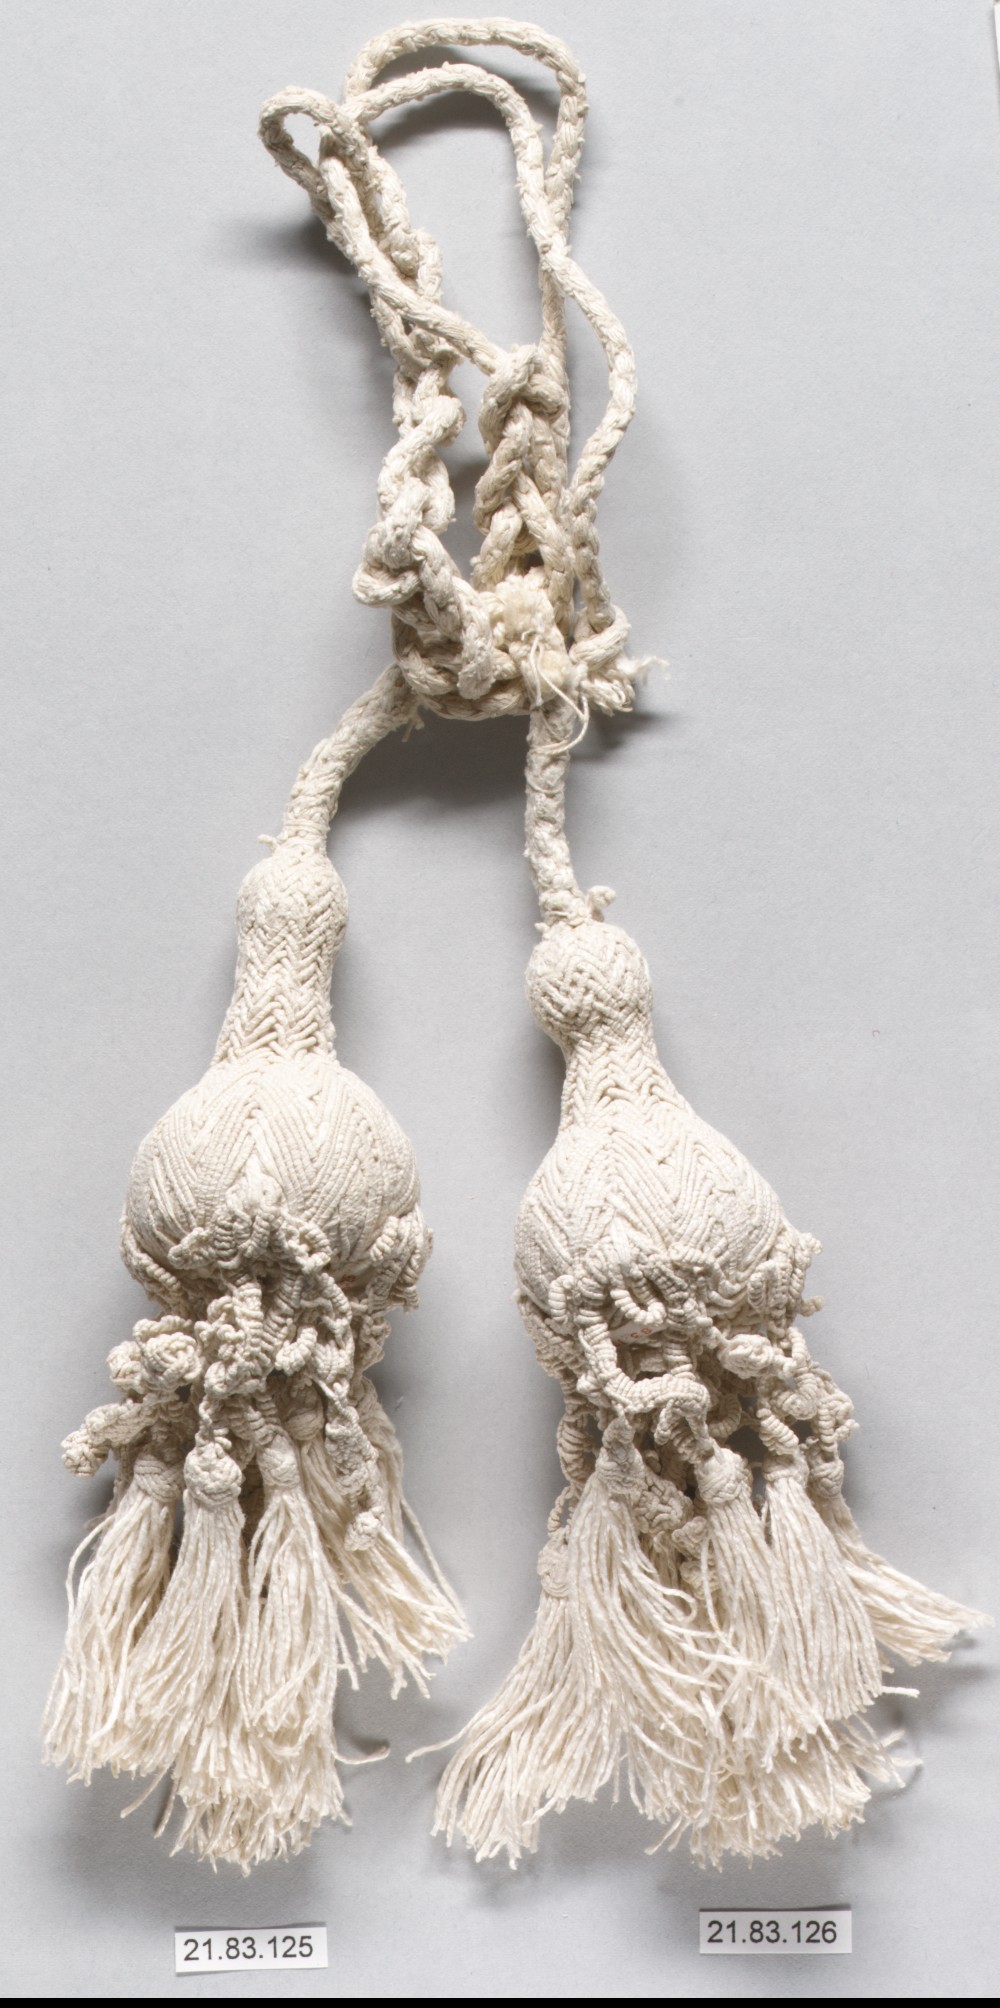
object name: tassel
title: Pair of tassels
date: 1601-1700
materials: linen